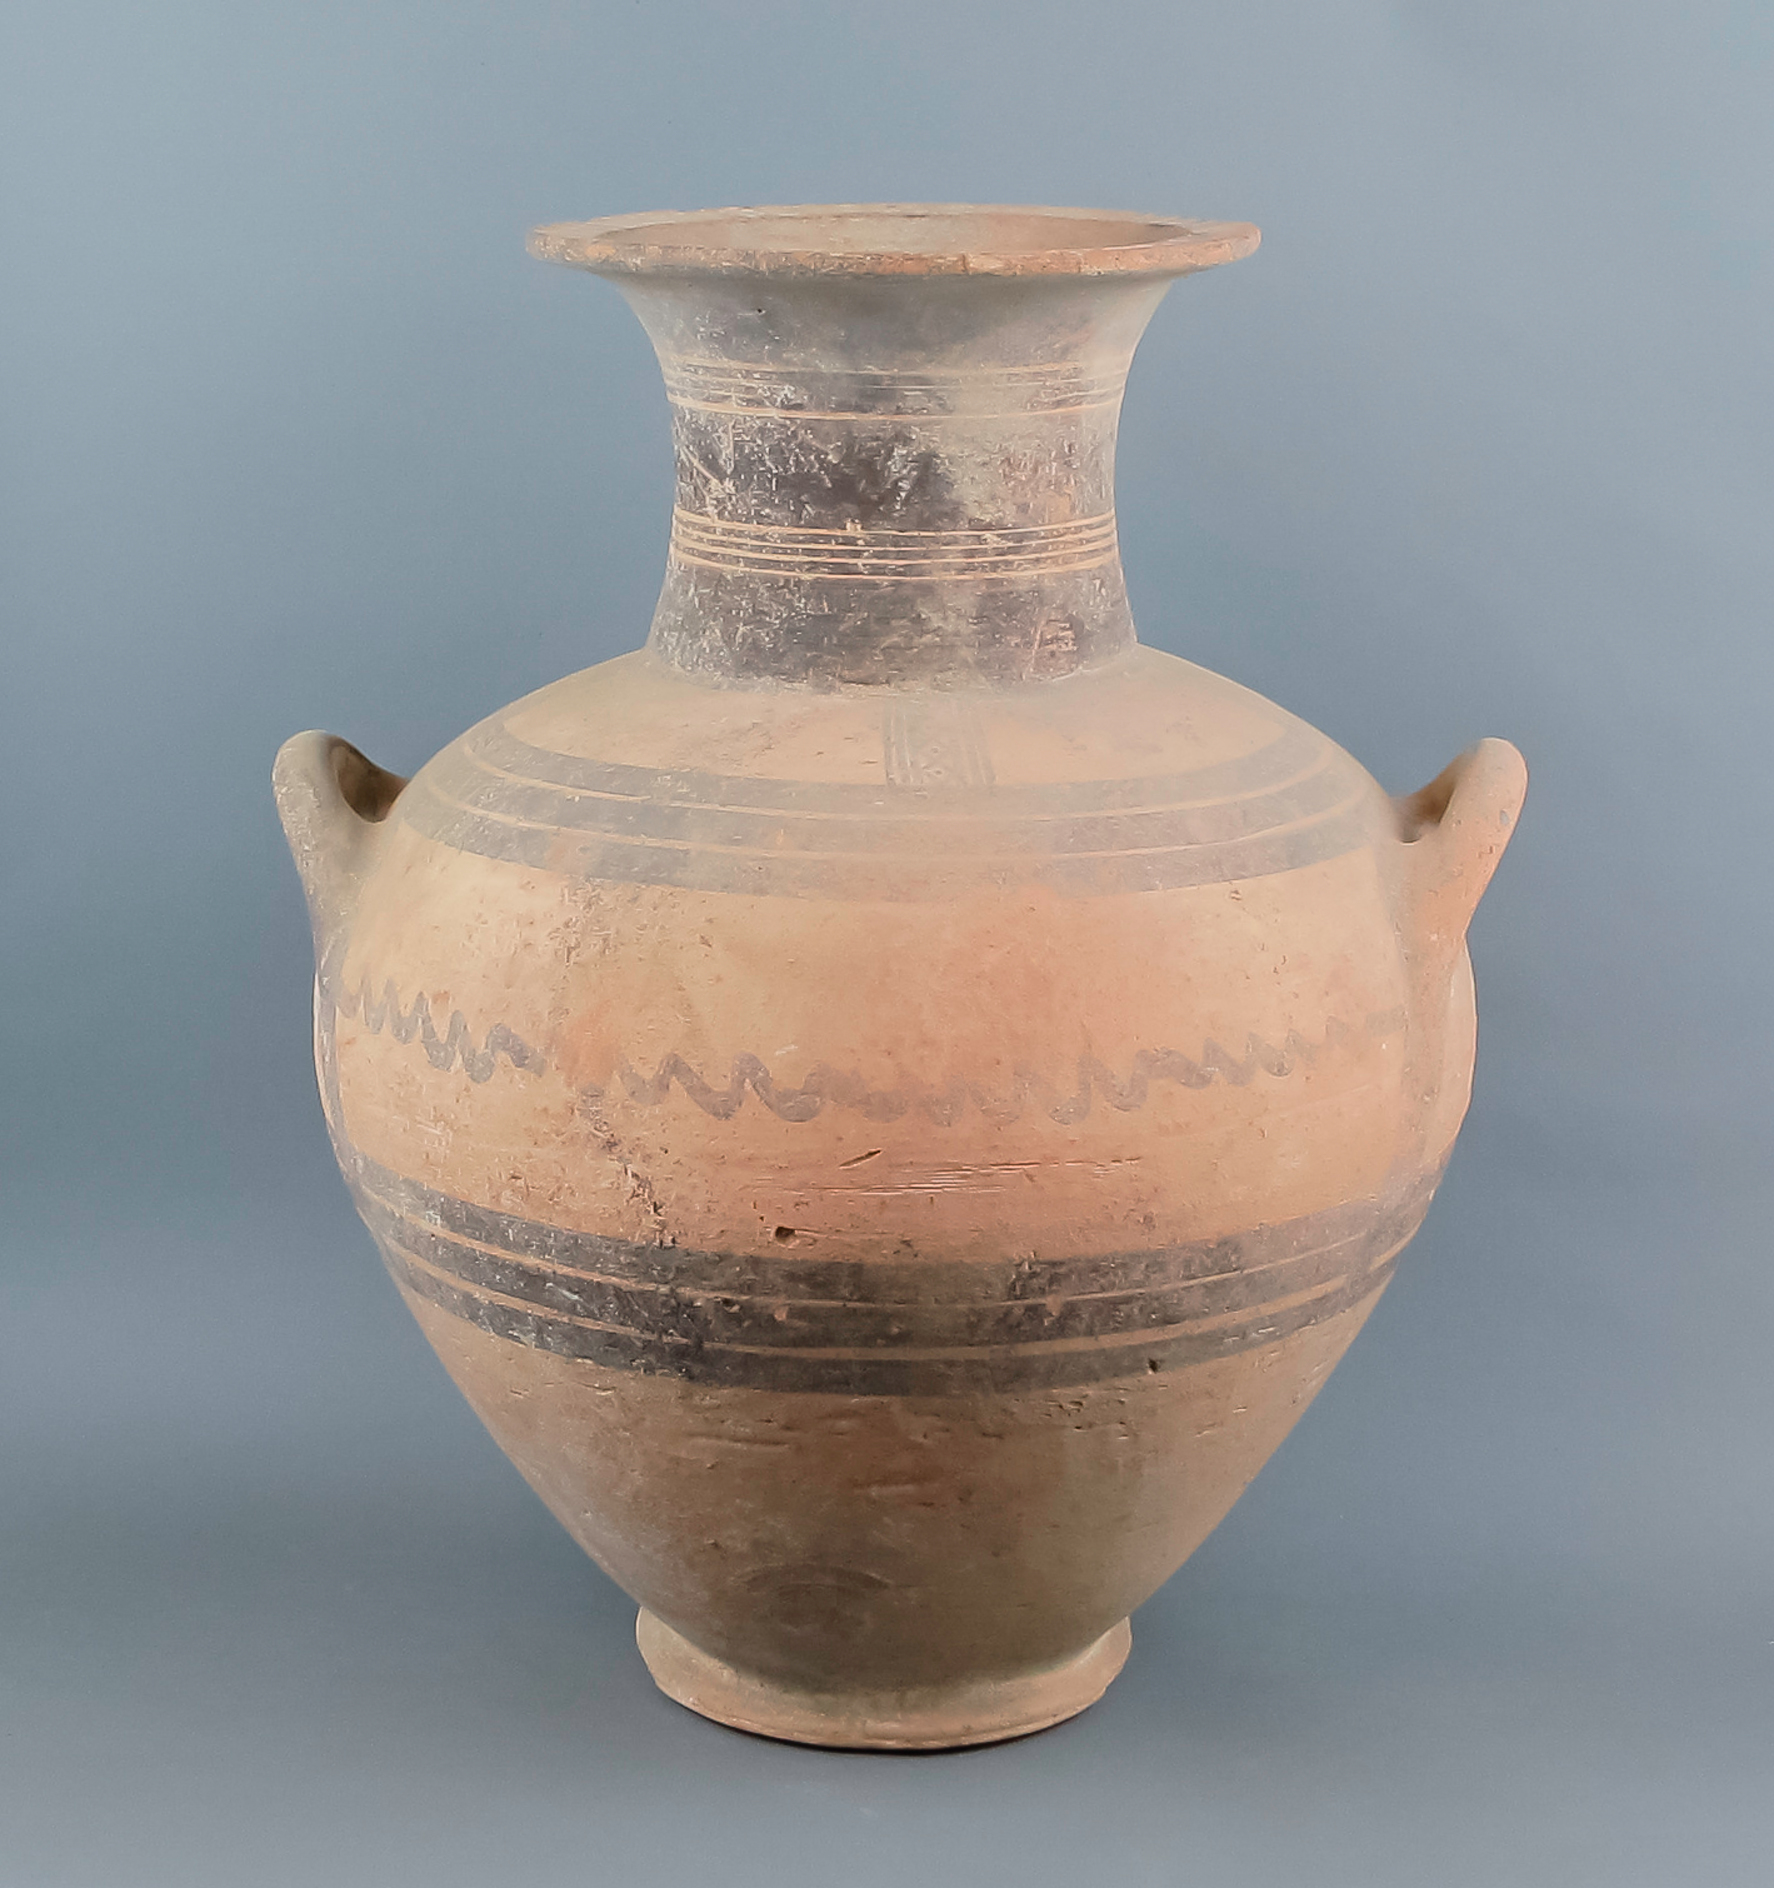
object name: amphora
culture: cypriot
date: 1125-1050 BCE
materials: terracotta